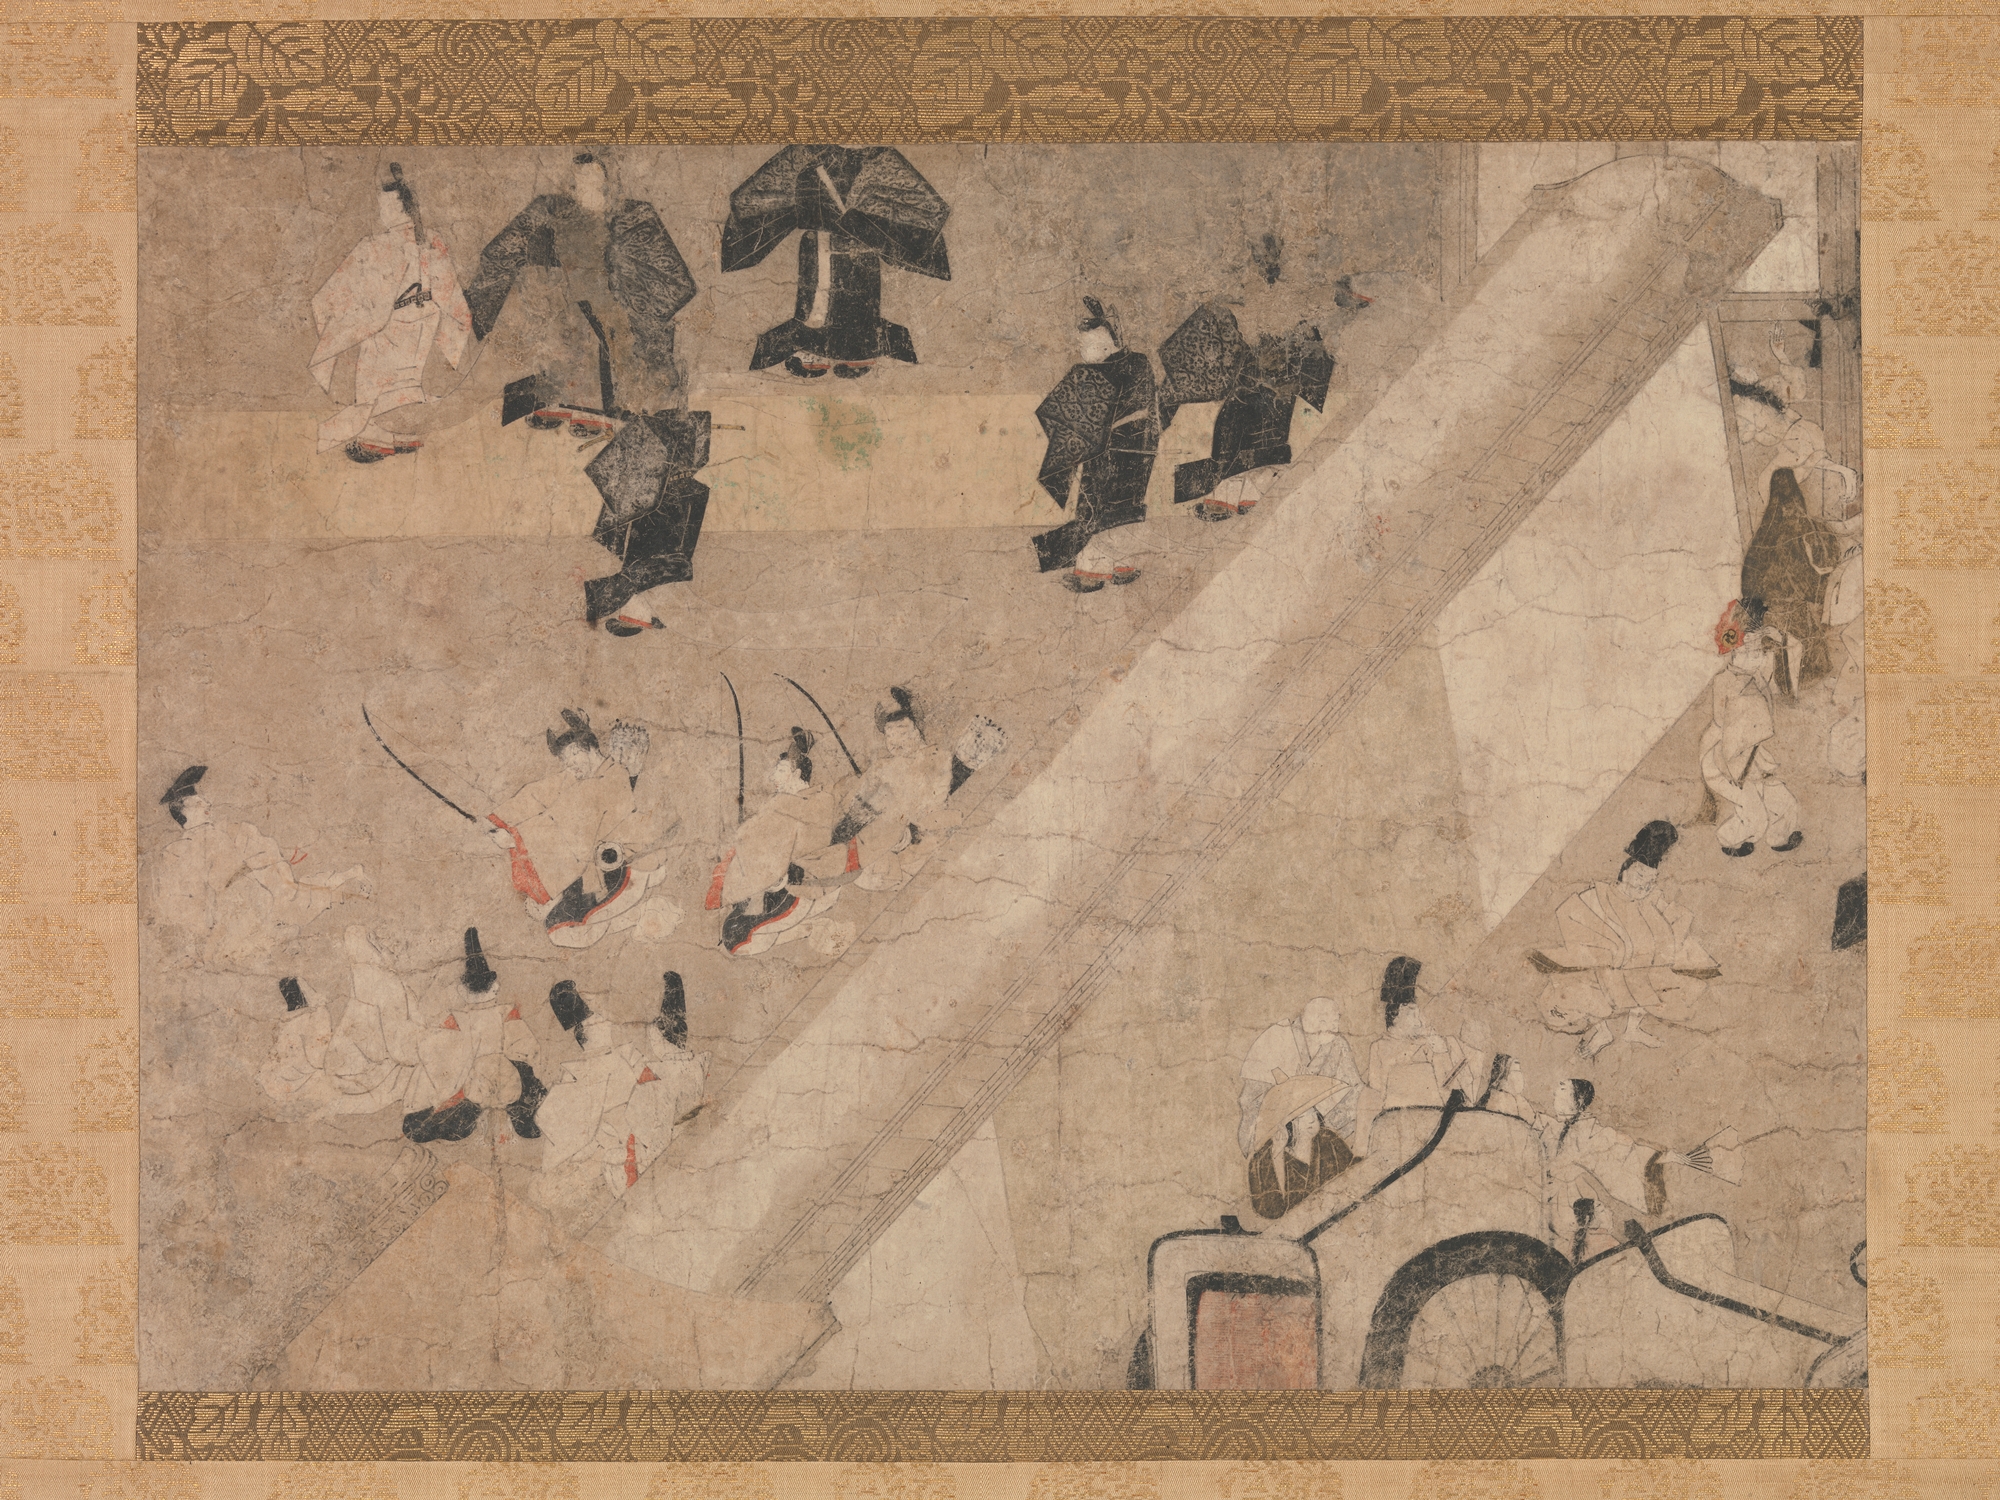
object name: hanging scroll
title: "Imperial Visit to the Great Horse Race at the Kaya-no-in Mansion" from the Tale of Flowering Fortunes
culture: japanese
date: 1201-1400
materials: ink, paper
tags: men